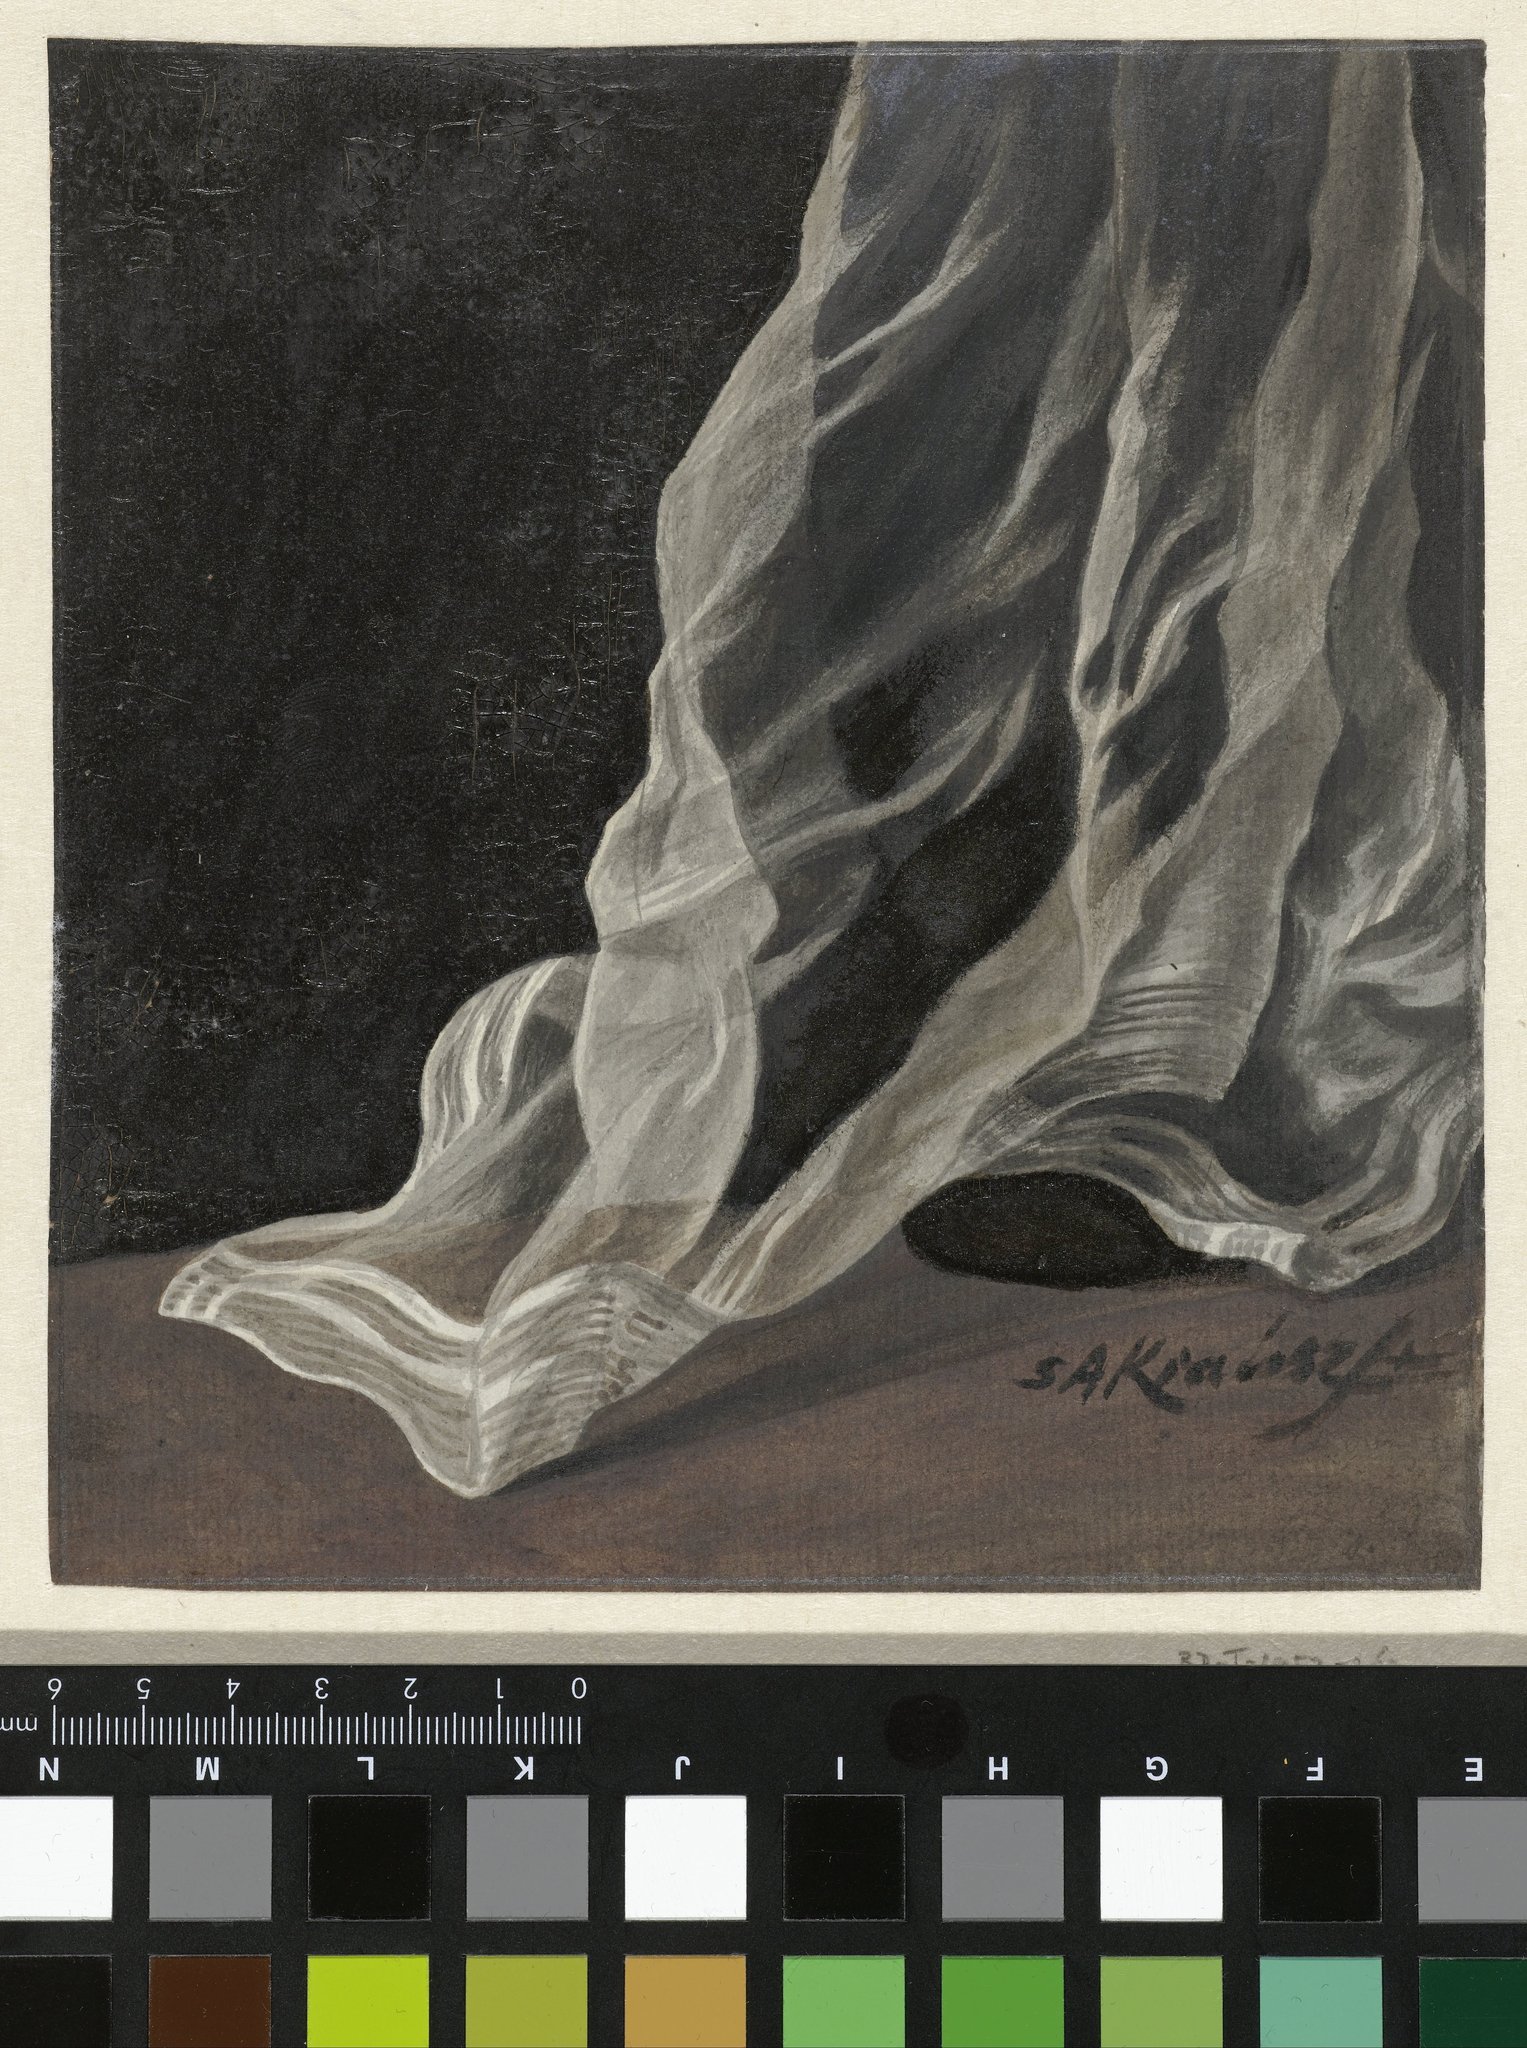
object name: drawing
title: Draperiestudie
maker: simon andreas krausz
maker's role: draughtsman, print maker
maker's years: 1760-1825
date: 1770-1825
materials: oil, paper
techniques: brush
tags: drapery, draped garment, 'gewandgebung'